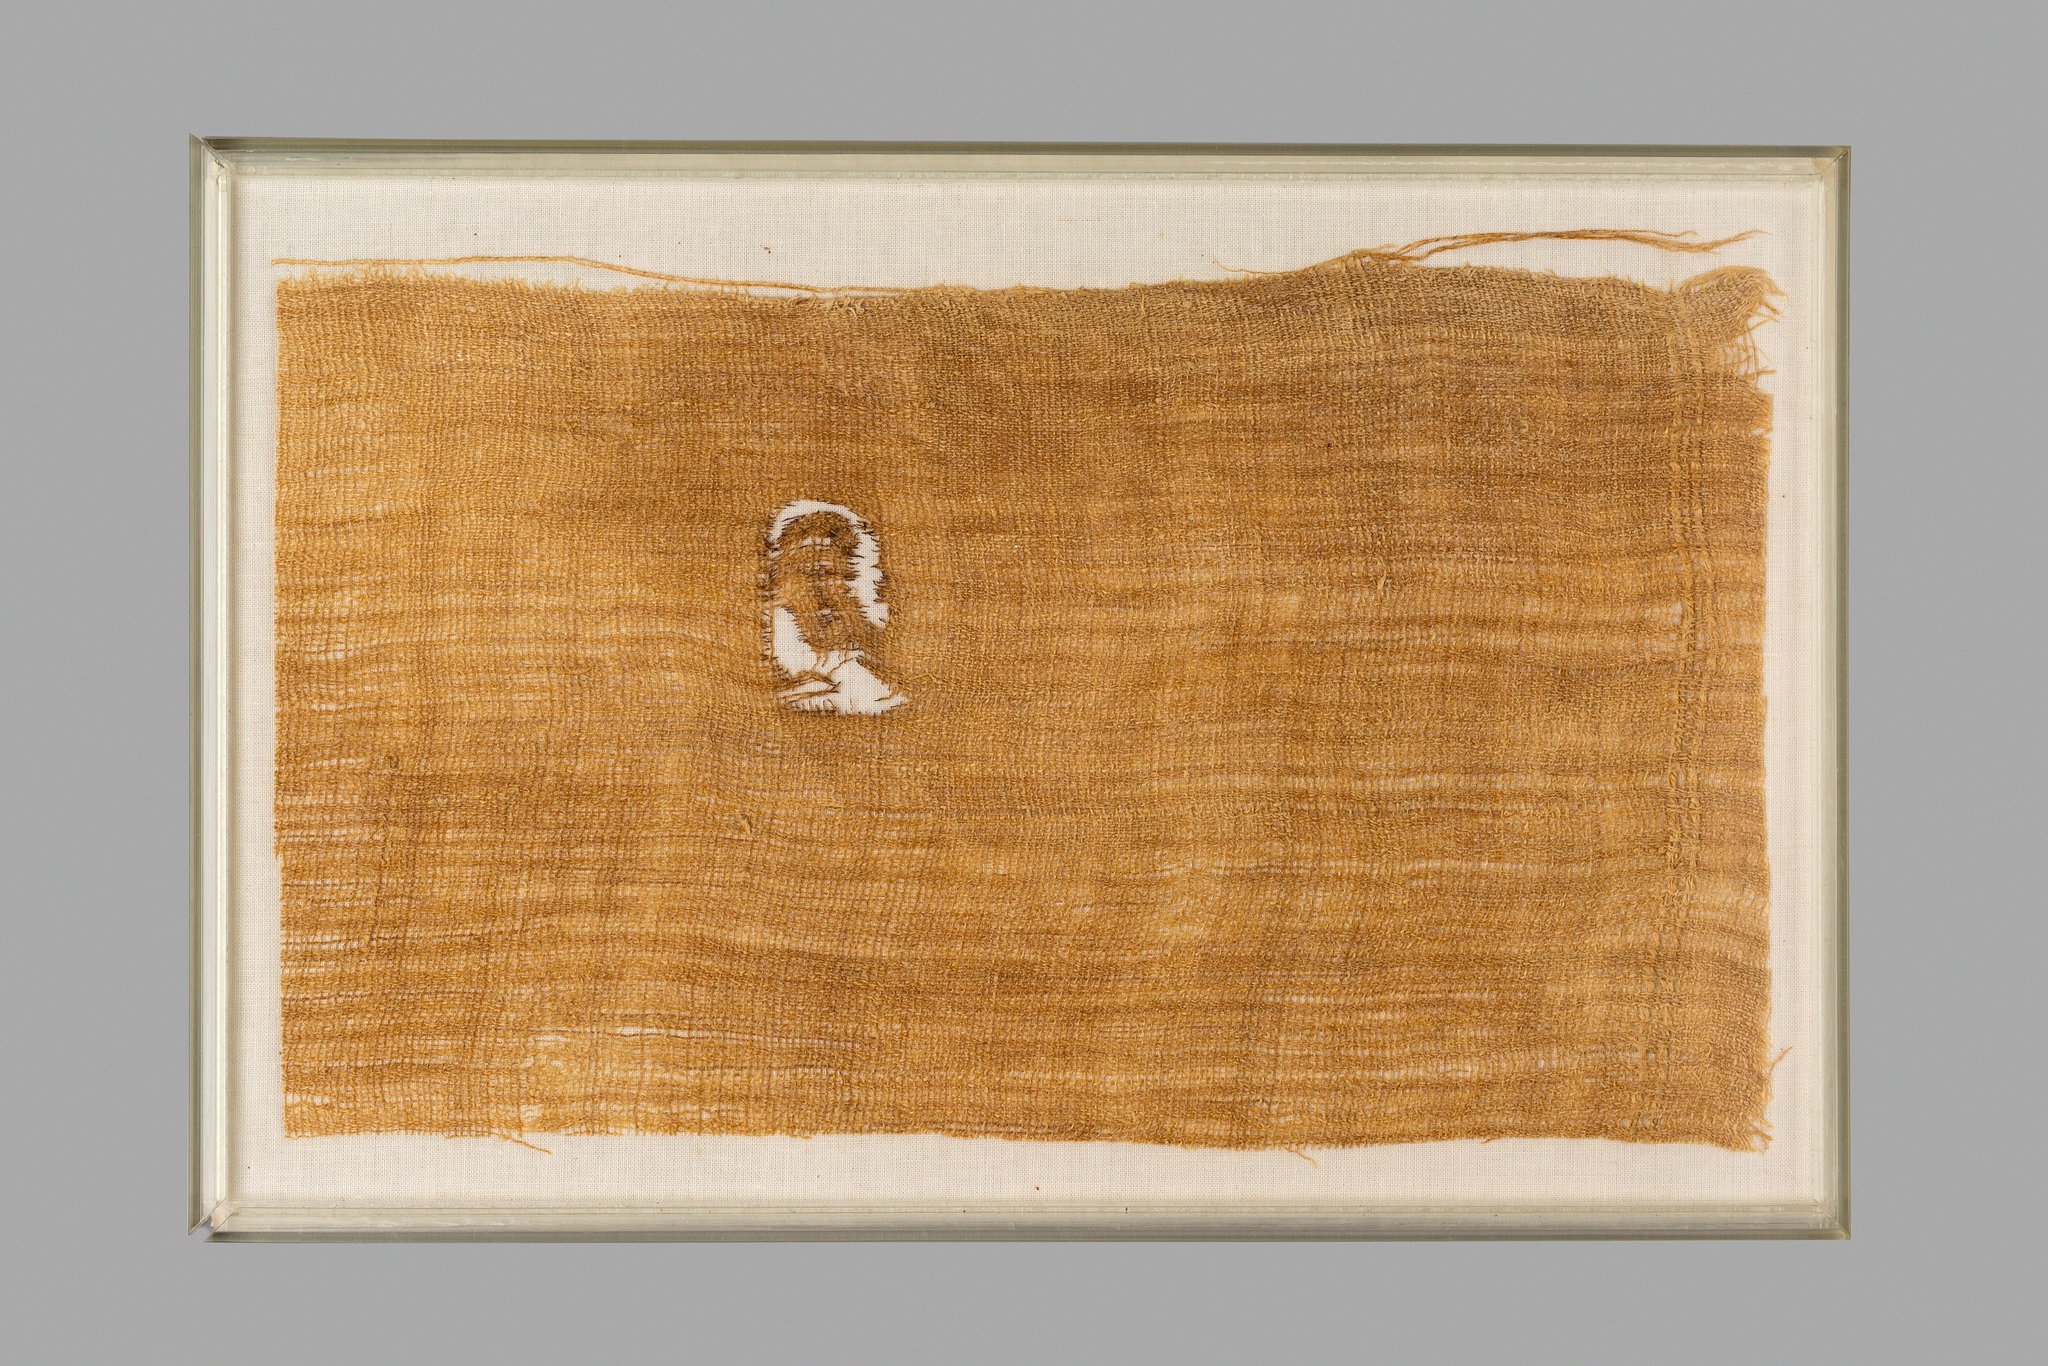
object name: linen sheet fragment, inscribed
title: Corner of a Sheet Inscribed with the Cartouche of Neferure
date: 1492-1473 BCE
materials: ink, linen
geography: egypt